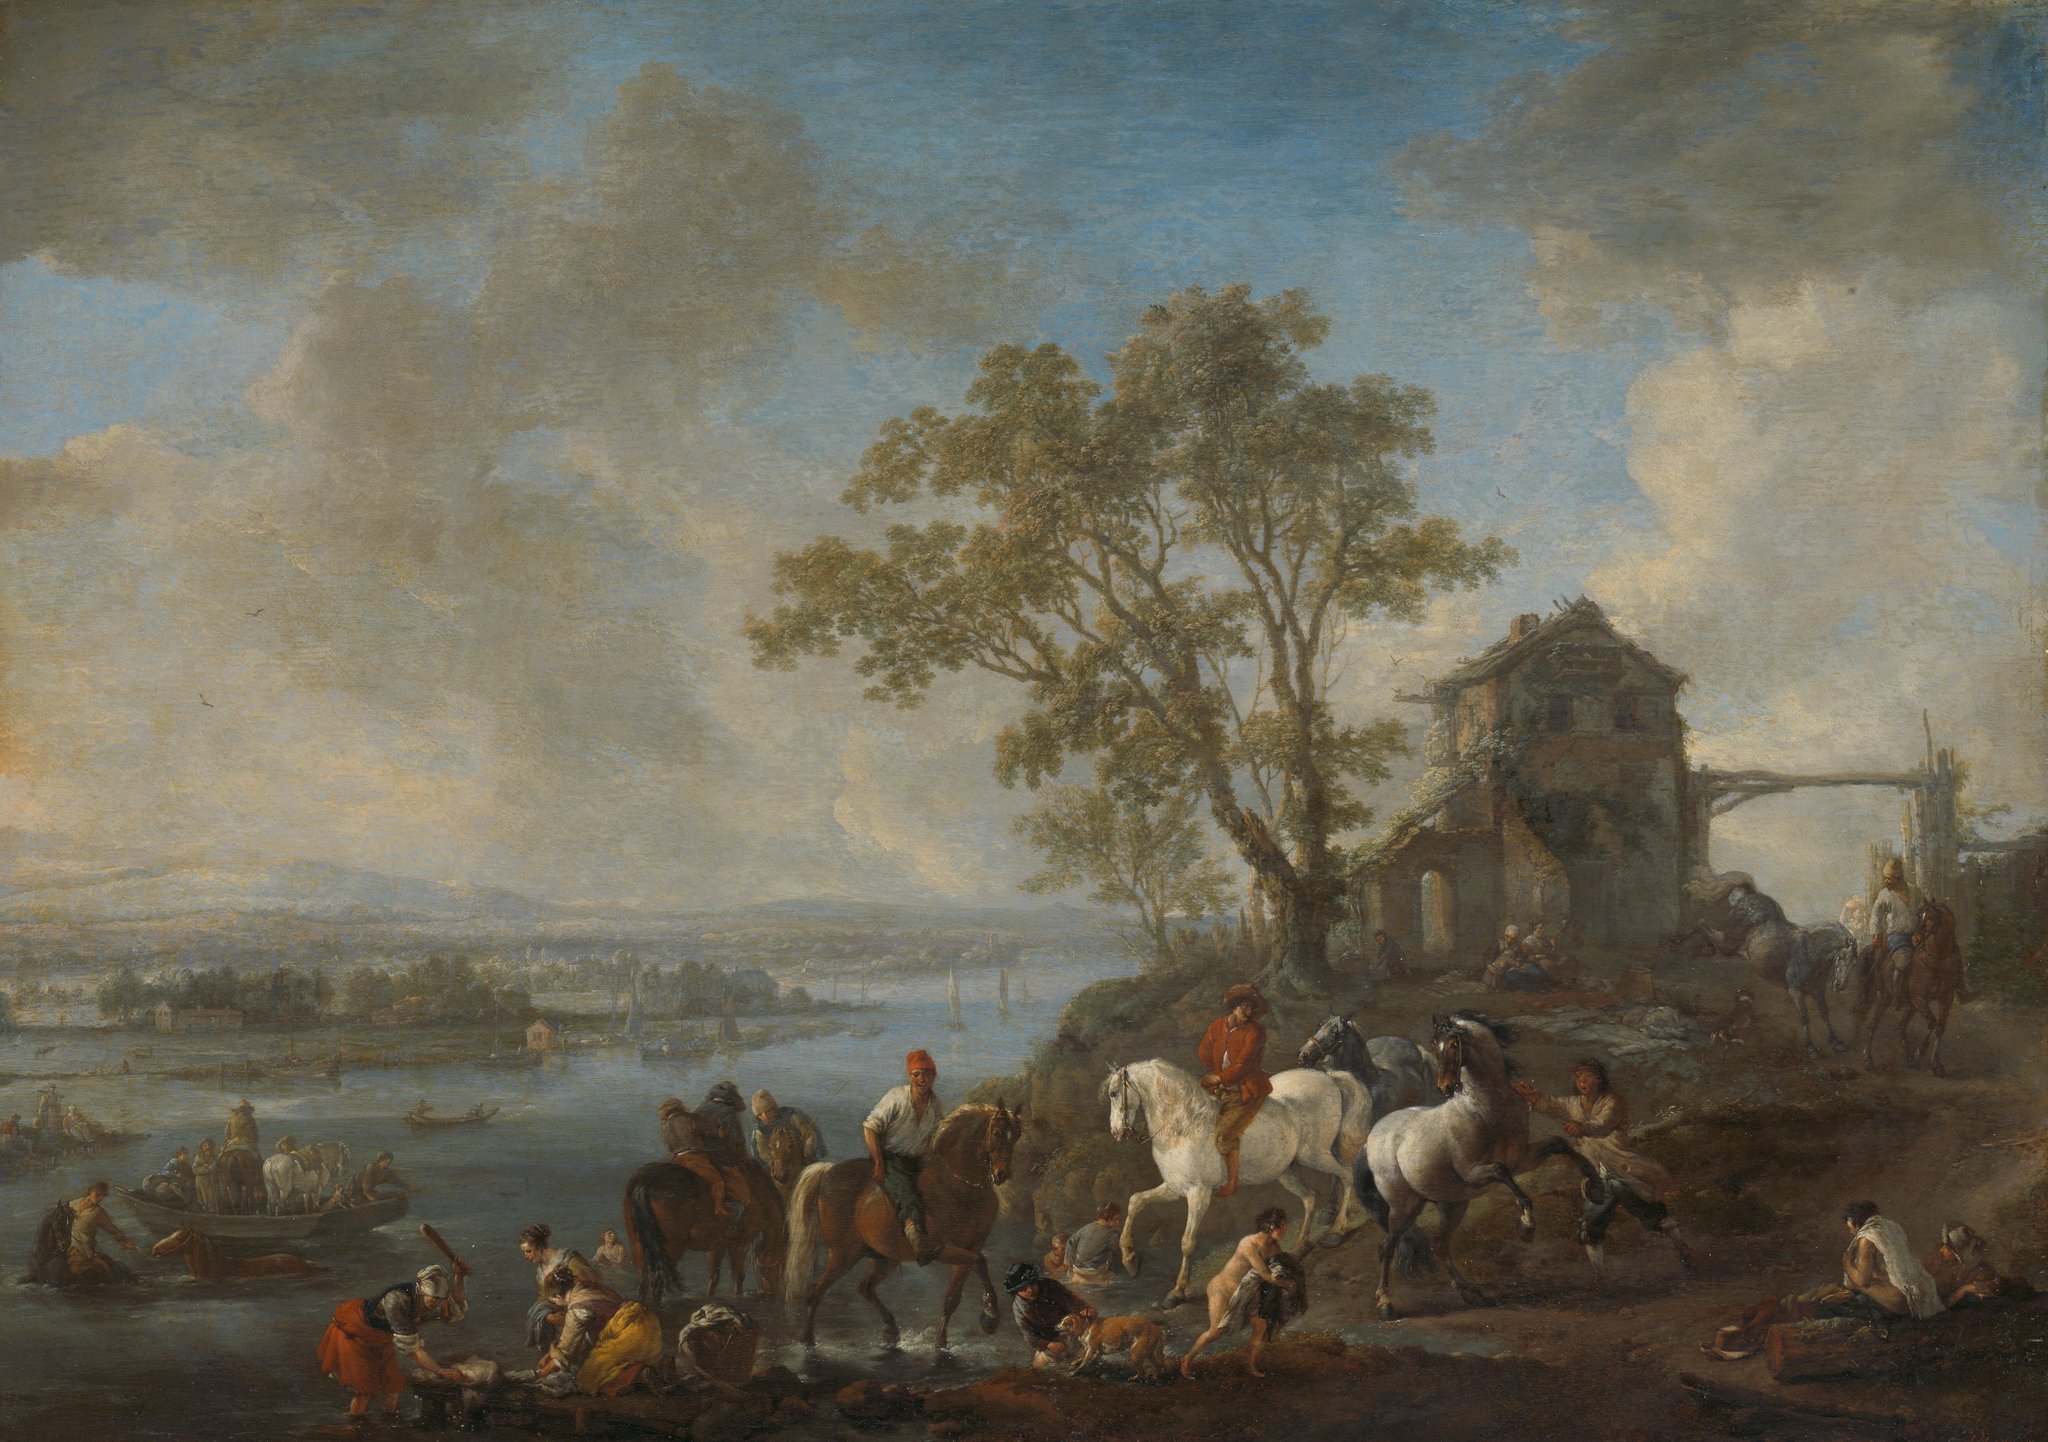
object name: painting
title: Horsepond on a River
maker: philips wouwerman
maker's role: draughtsman, painter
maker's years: 1619-1668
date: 1662-1663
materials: oil, panel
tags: riding a horse, ass, or mule; rider, horseman, river, ferry, laundering, horse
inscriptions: signature, with monogram, bottom right (letters of first name ligated): ‘PHils . W’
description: Ruiters laten hun paarden baden en drinken terwijl een afgeladen veerboot aankomt bij de drukbevolkte waterkant. De blauwe lucht en het licht dat op de wolken schijnt verraden het krieken van de ochtend. De met paarden en mensen gestoffeerde landschappen van Philips Wouwerman behoorden vanaf de vroege 18de eeuw tot de meest gezochte Hollandse schilderijen.